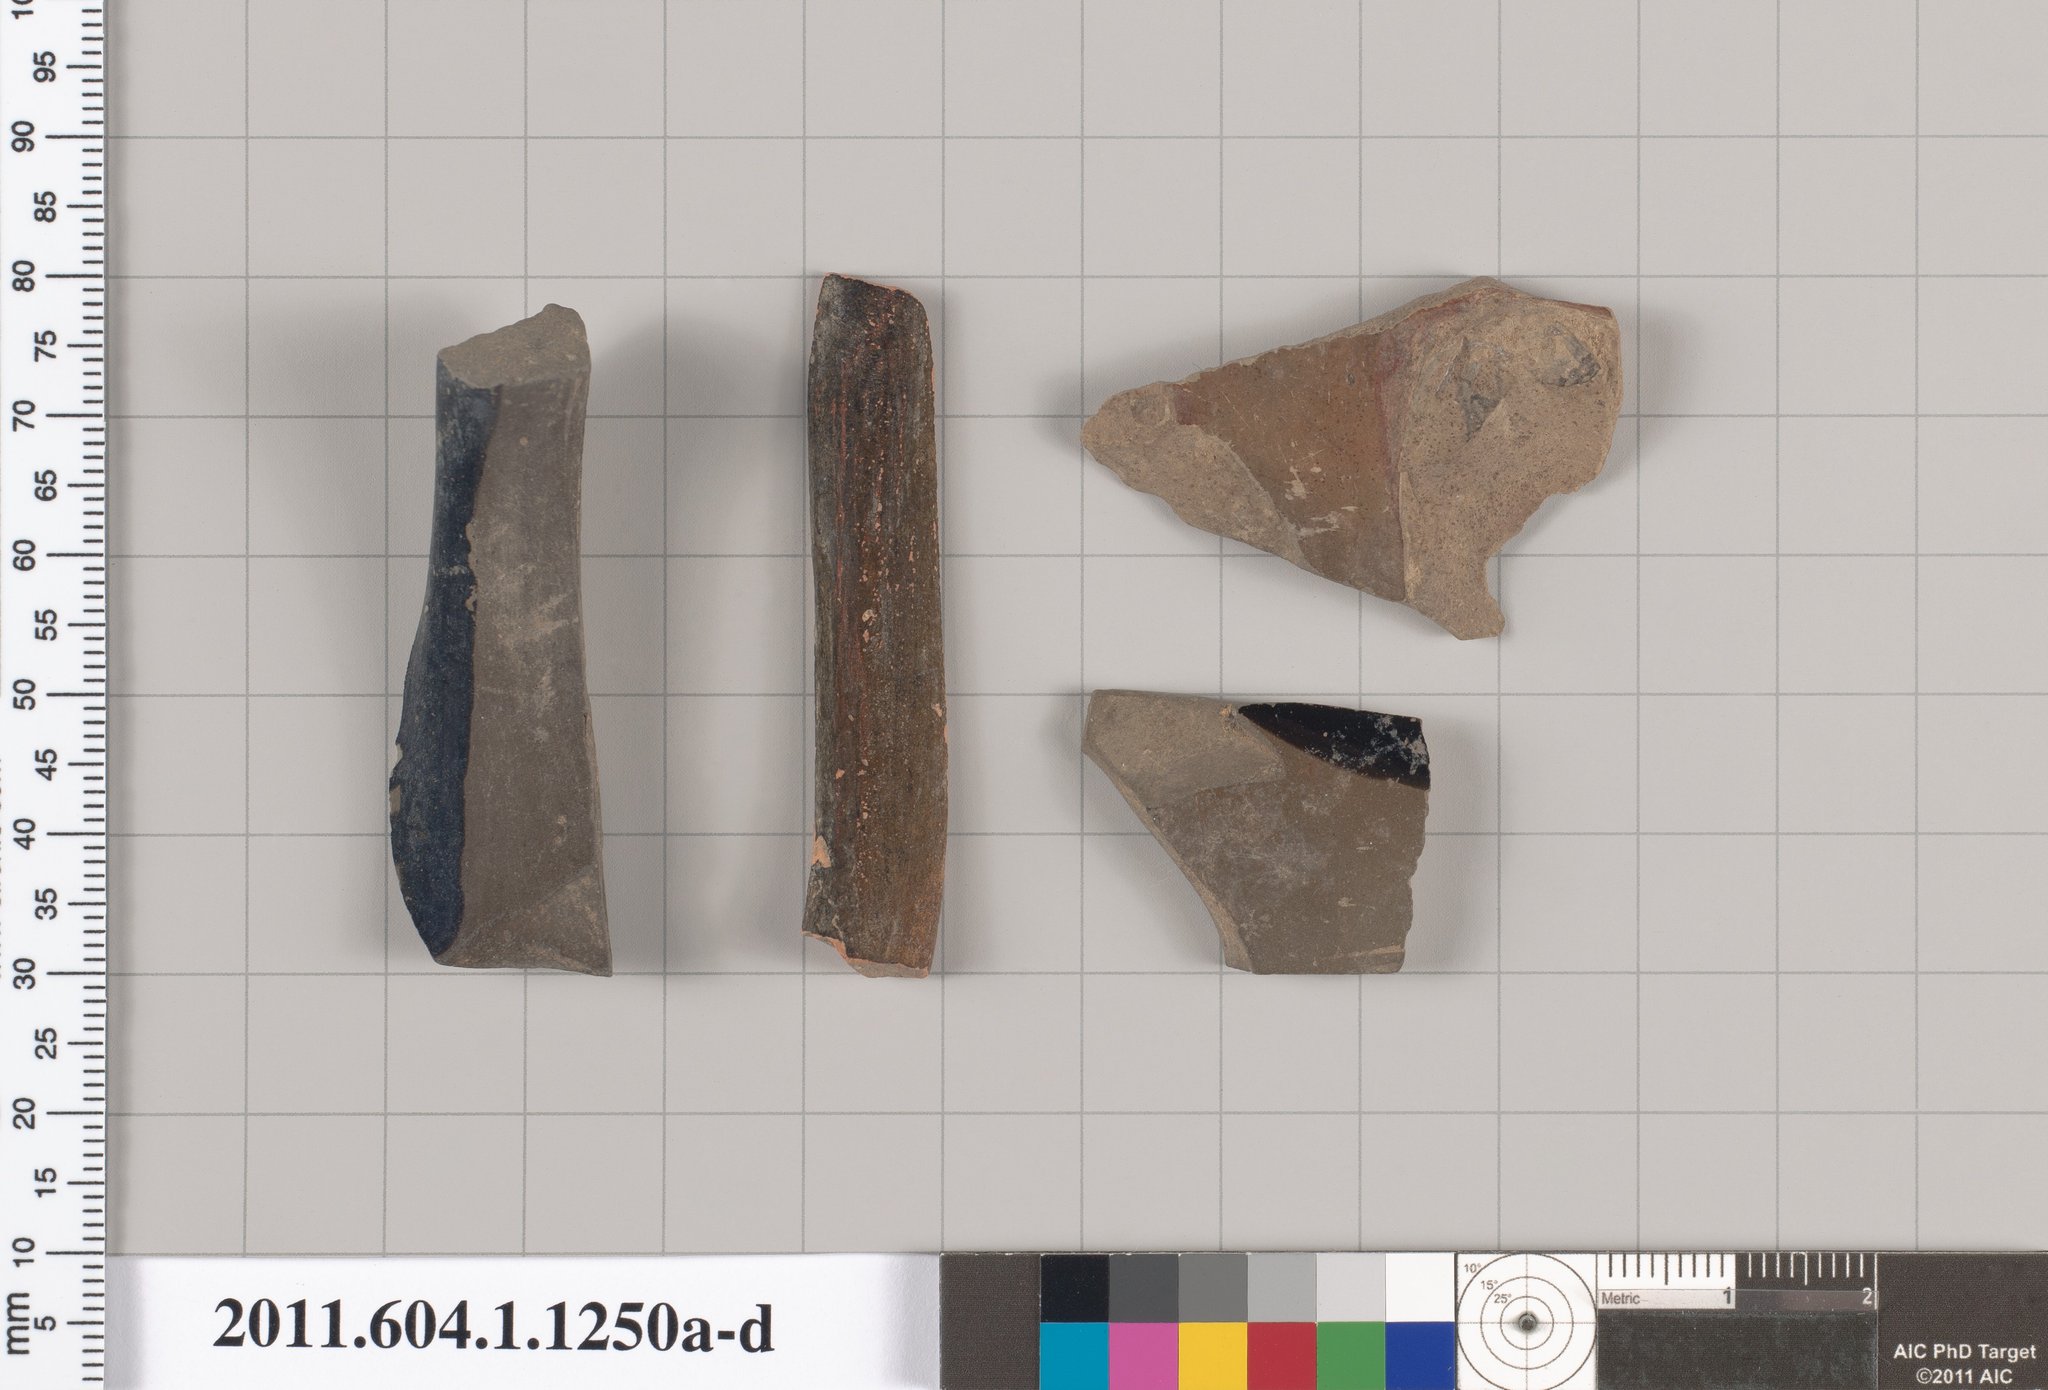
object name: kylix fragment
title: Terracotta fragments of kylikes (drinking cups)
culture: greek, attic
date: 500-401 BCE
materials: terracotta